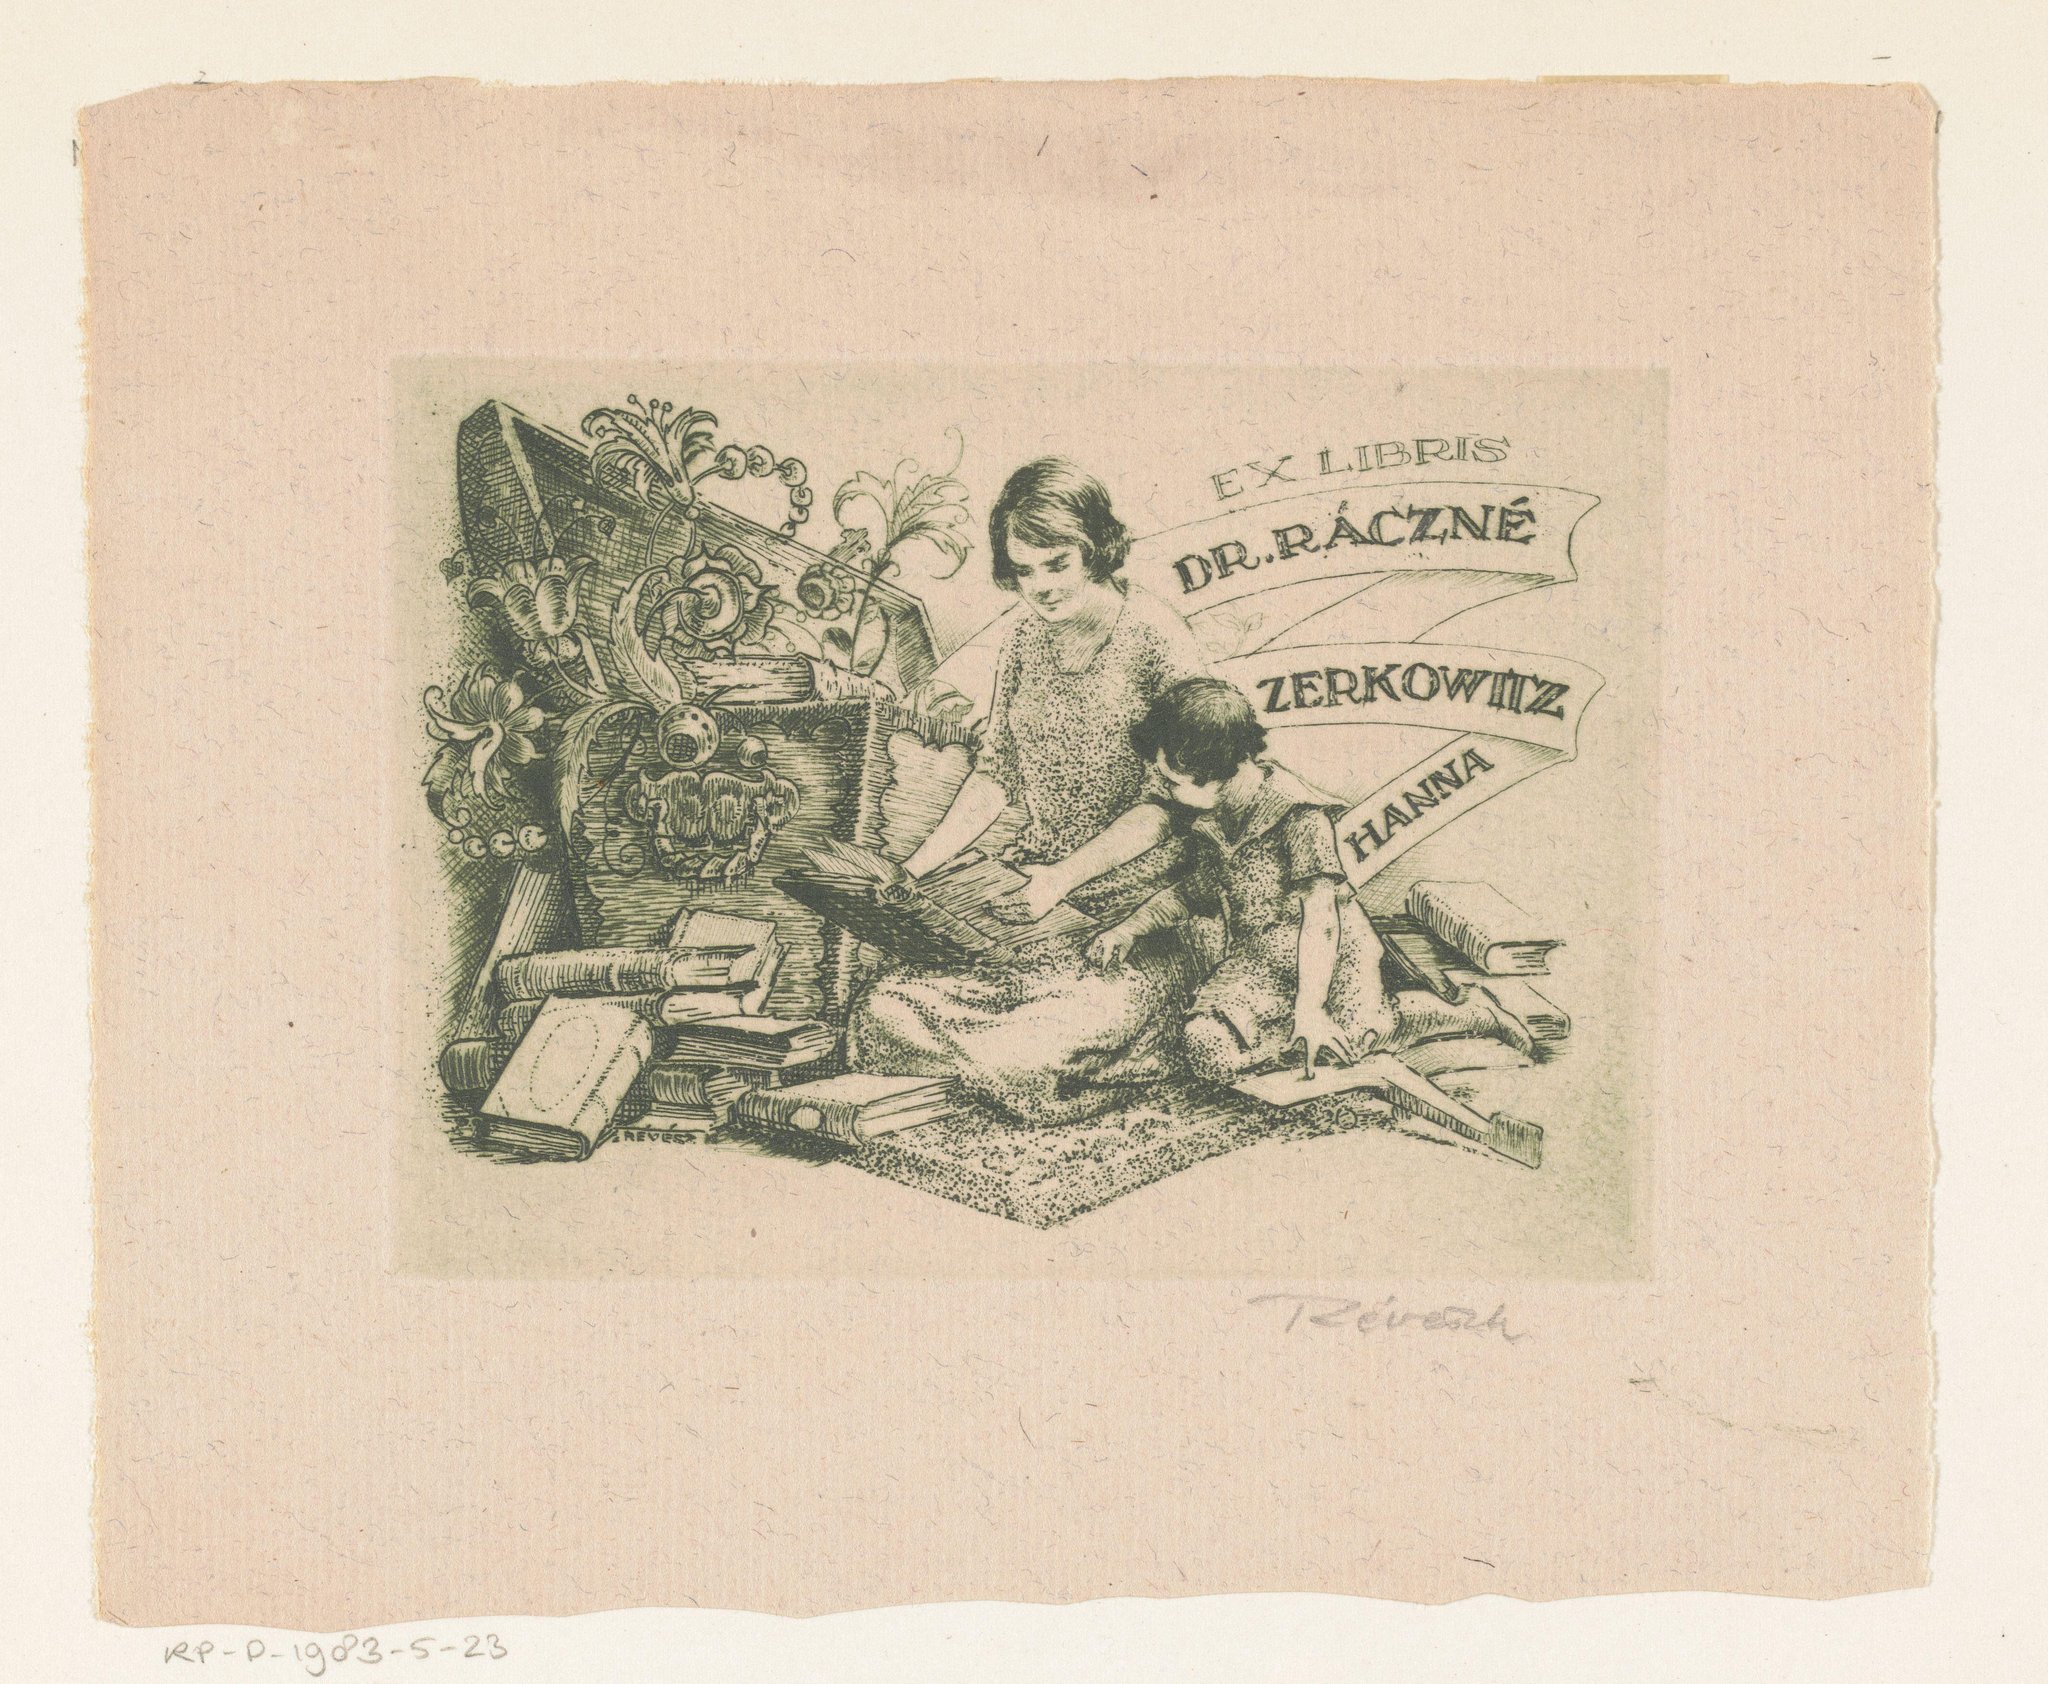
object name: bookplate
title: Ex libris dr. Ráczné Zerkowitz Hanna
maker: kornél révész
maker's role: print maker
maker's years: 1885-1944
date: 1935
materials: paper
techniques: drypoint, etching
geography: budapest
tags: fantastic plants, fabulous vegetation, book, mother and baby or young child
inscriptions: date: ‘Nr. 114/ 1935’, signature: ‘Révész’, workshop stamp: ‘Fecit/ Révész Kornél/ Budapest’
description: Ex libris maakt deel uit van omslag met 64 ex libris op 34 losse opzetvellen, een catalogus en een tekstblad.